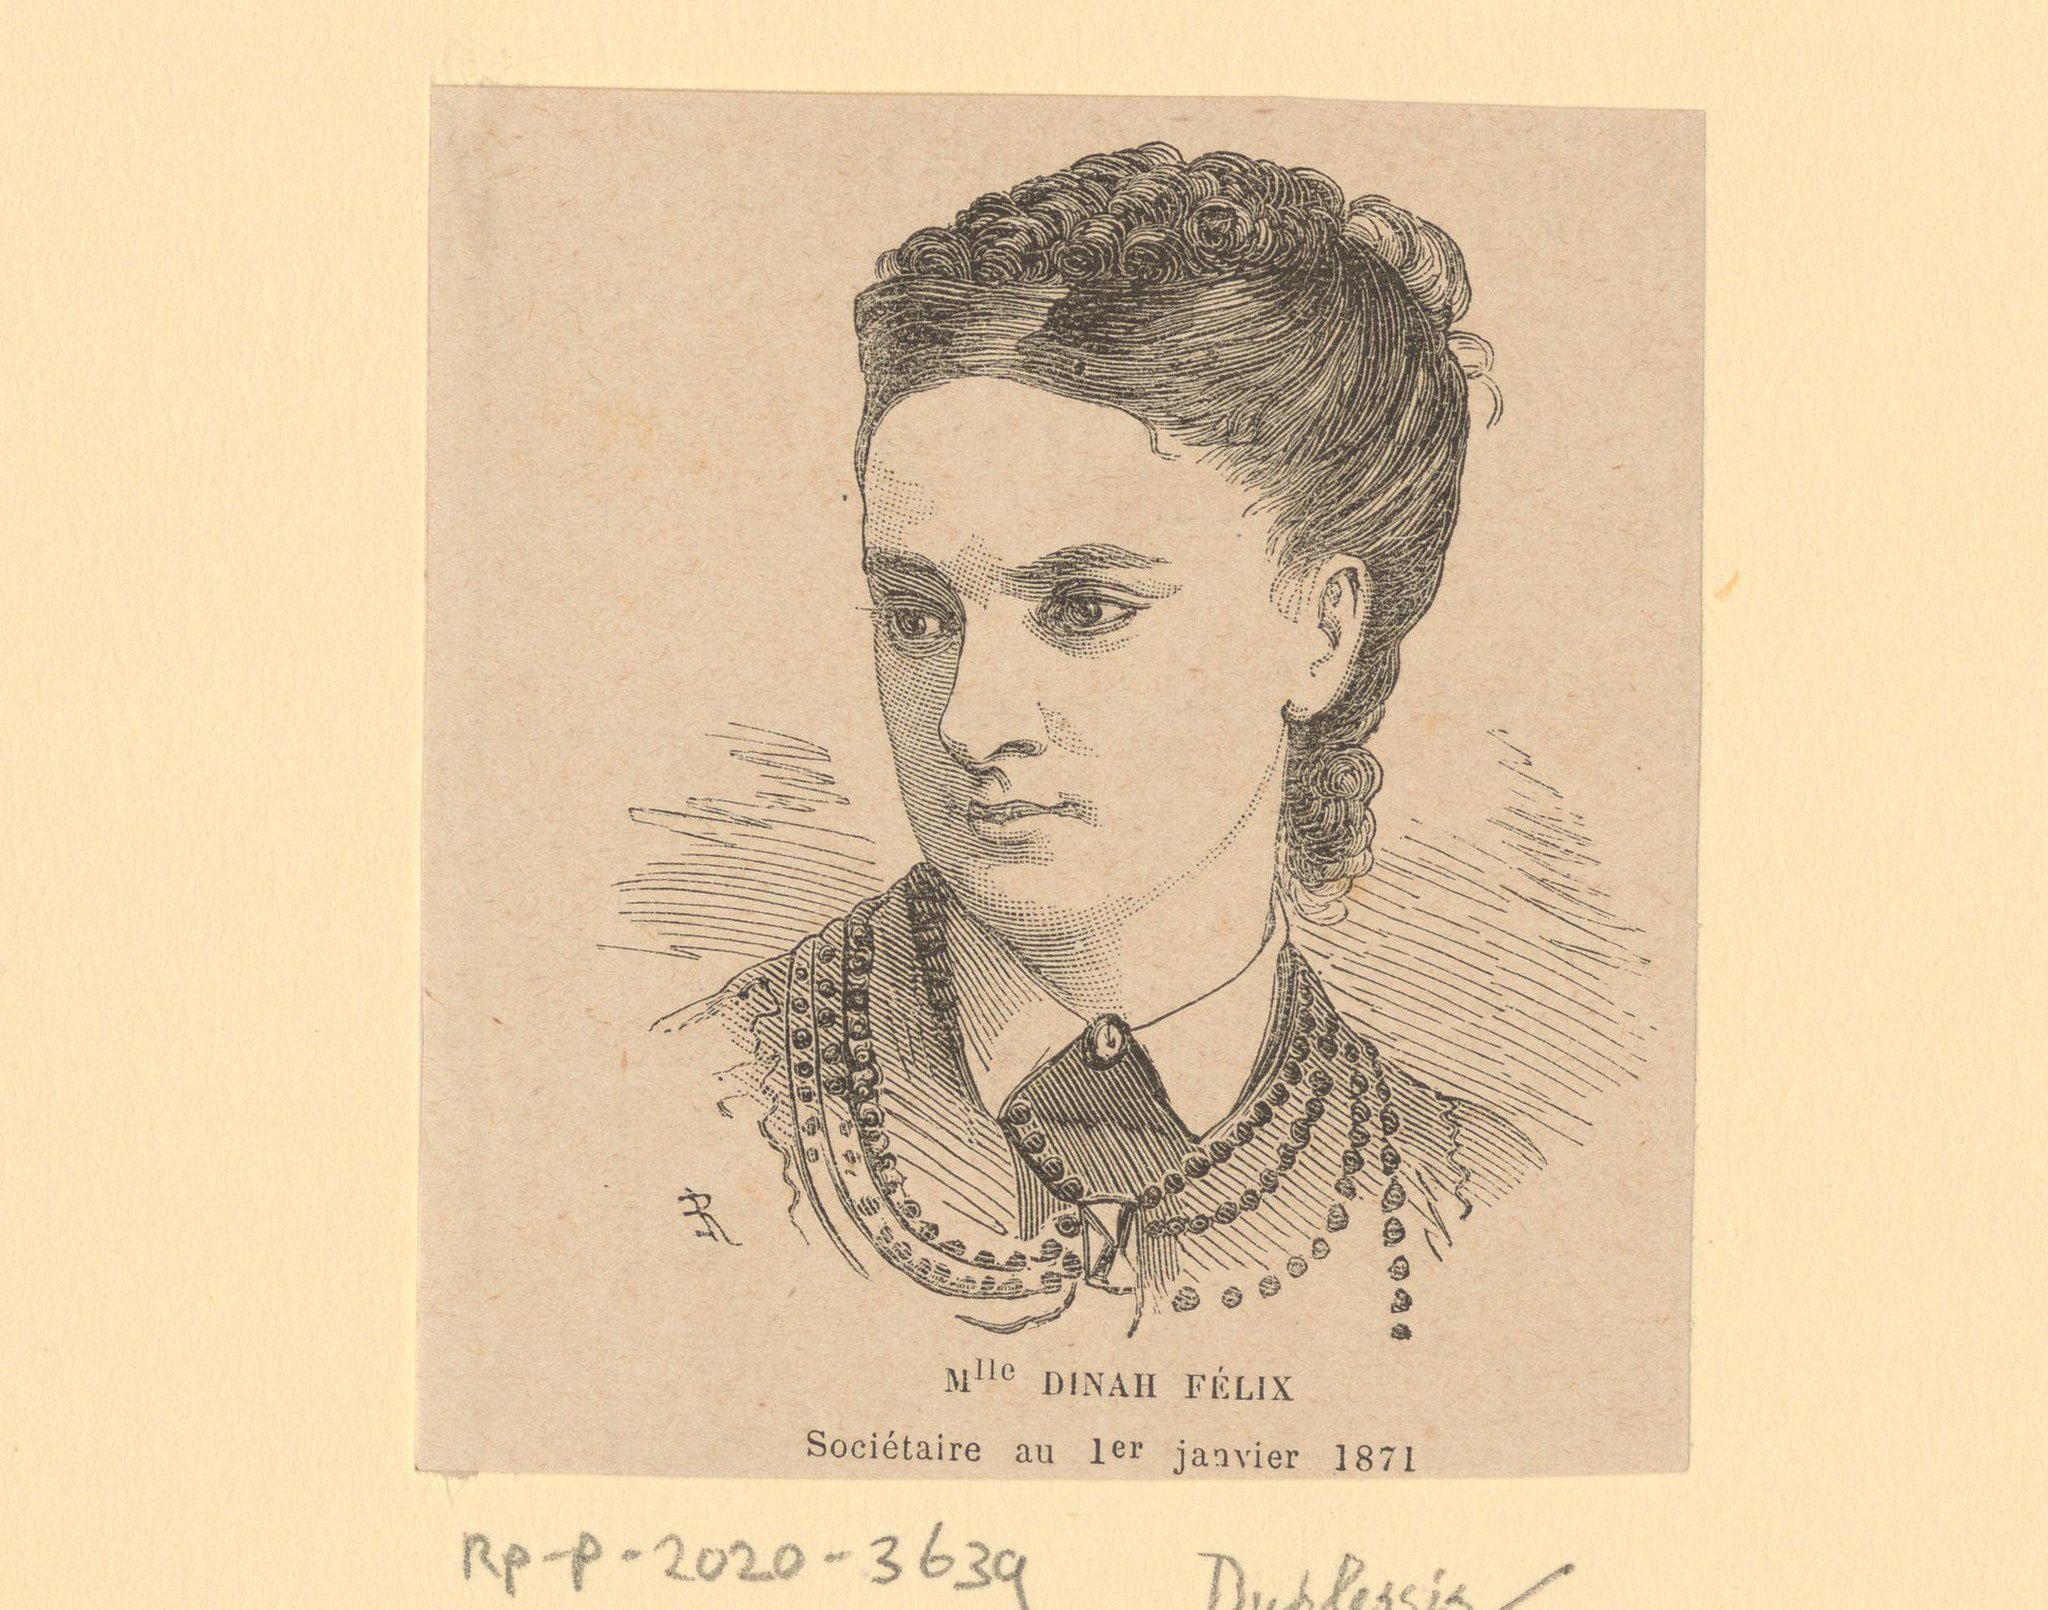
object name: print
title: Portret van Dinah Félix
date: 1879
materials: paper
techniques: letterpress printing, engraving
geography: paris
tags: historical persons - bb - woman, portrait of actor, actress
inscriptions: monogram: ‘ER [?]’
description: Prent uit: Le Monde Illustré 23 (1879), nr. 1163, 16 augustus 1879.